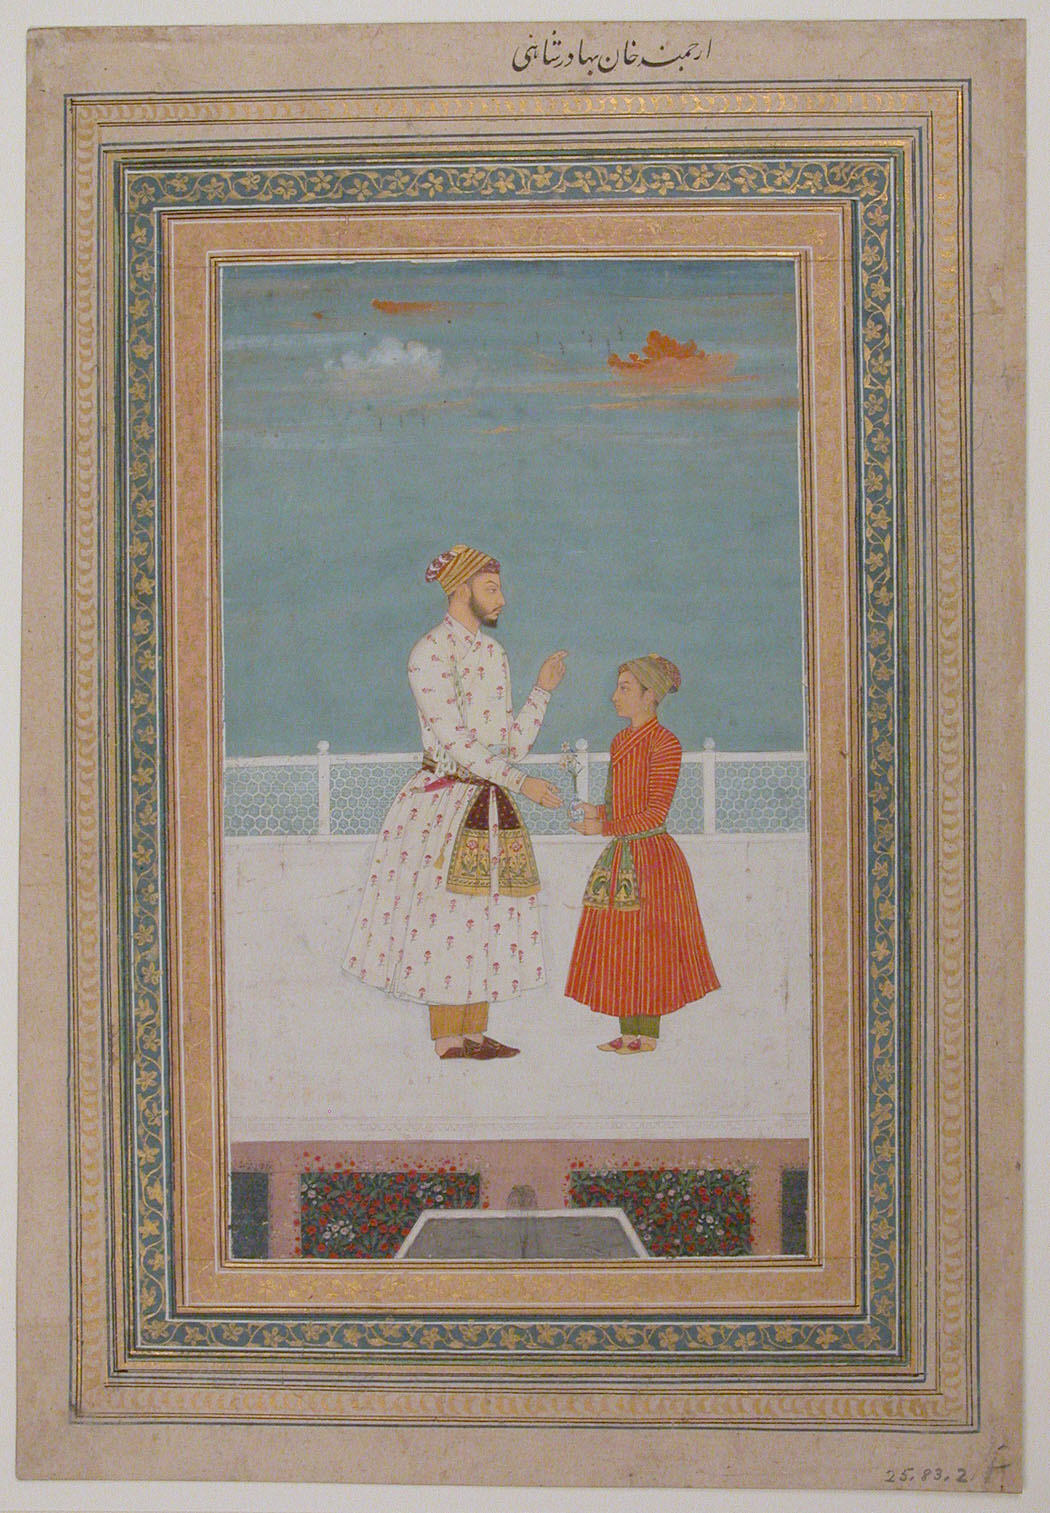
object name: album leaf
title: An Officer of Bahadur Shah and a Page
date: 1701-1800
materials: paper, watercolor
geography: india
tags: men